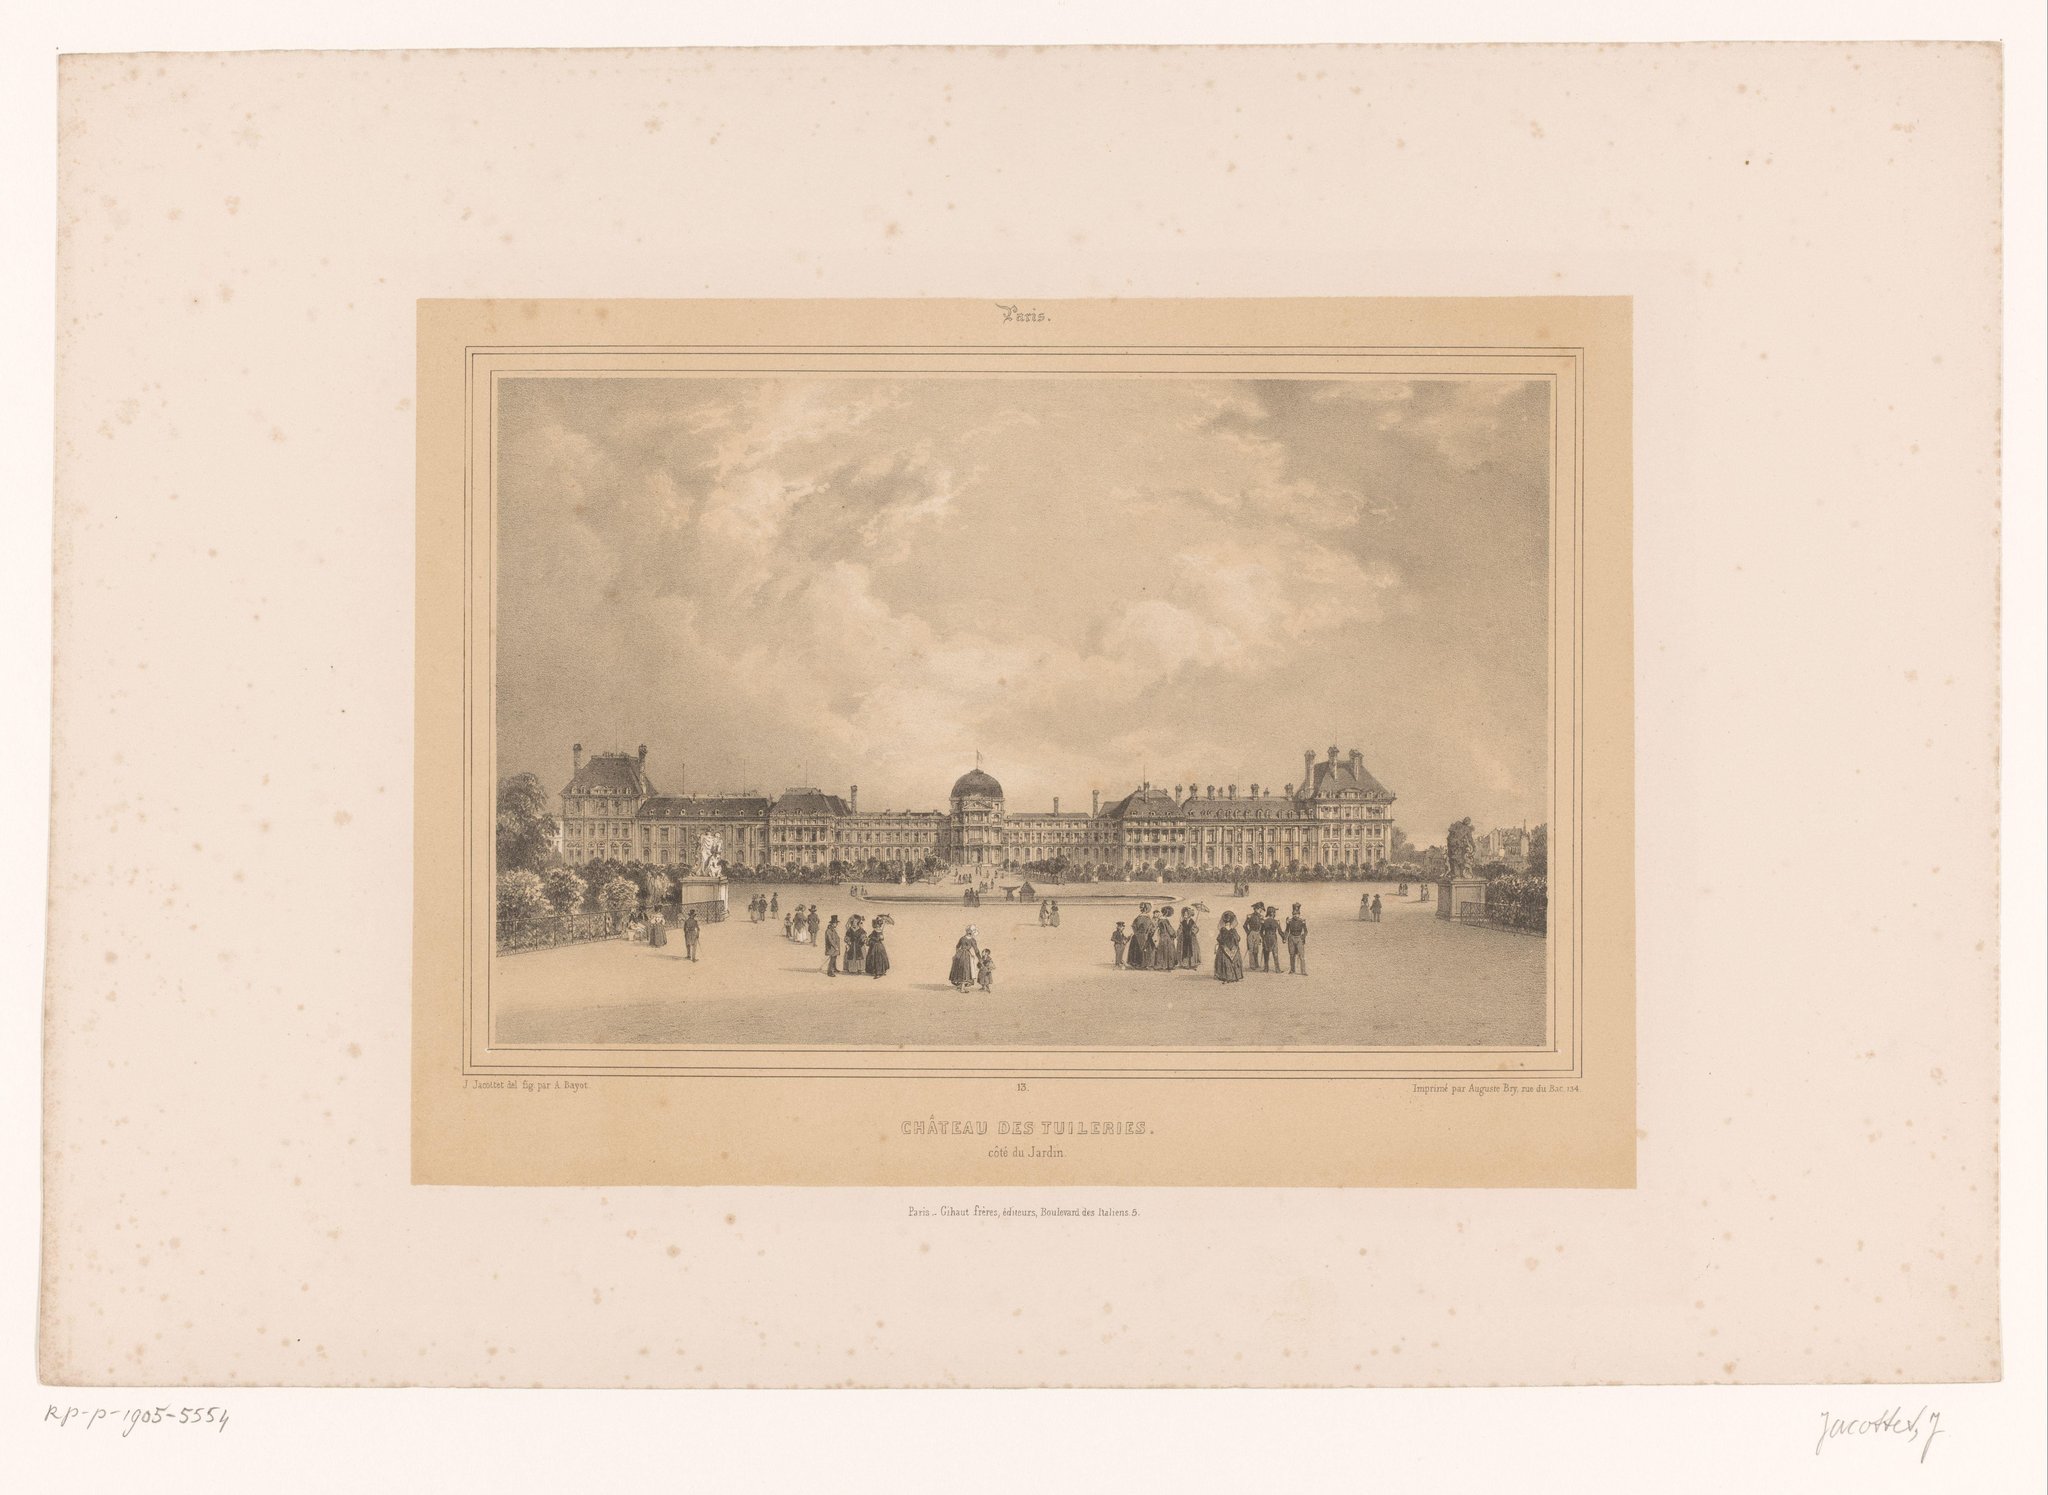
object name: print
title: Gezichten in en om Parijs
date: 1838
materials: paper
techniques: tone lithography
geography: paris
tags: public gardens, park (+ city(-scape) with figures, staffage), palace, tuileries palace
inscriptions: collector's mark: Lugt 2228a